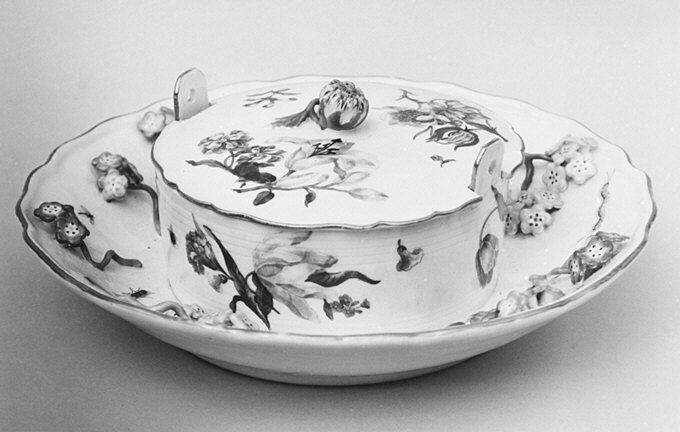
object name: butter dish with cover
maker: meissen manufactory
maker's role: manufactory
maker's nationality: german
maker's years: 1710-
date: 1701-1800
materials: hard paste porcelain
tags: flowers